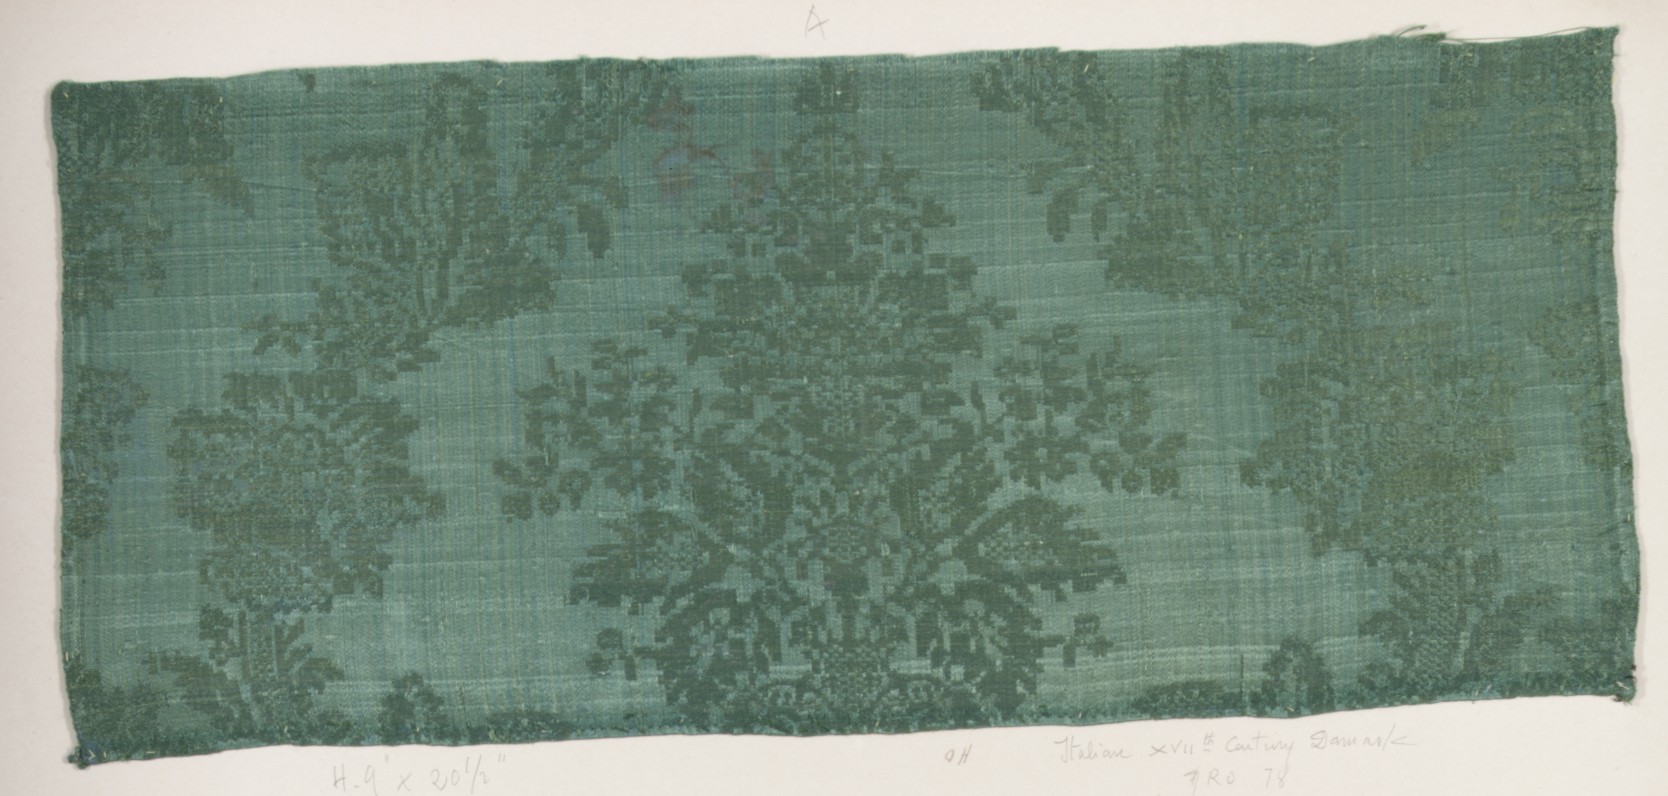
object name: fragment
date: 1601-1700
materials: silk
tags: flowers,leaves